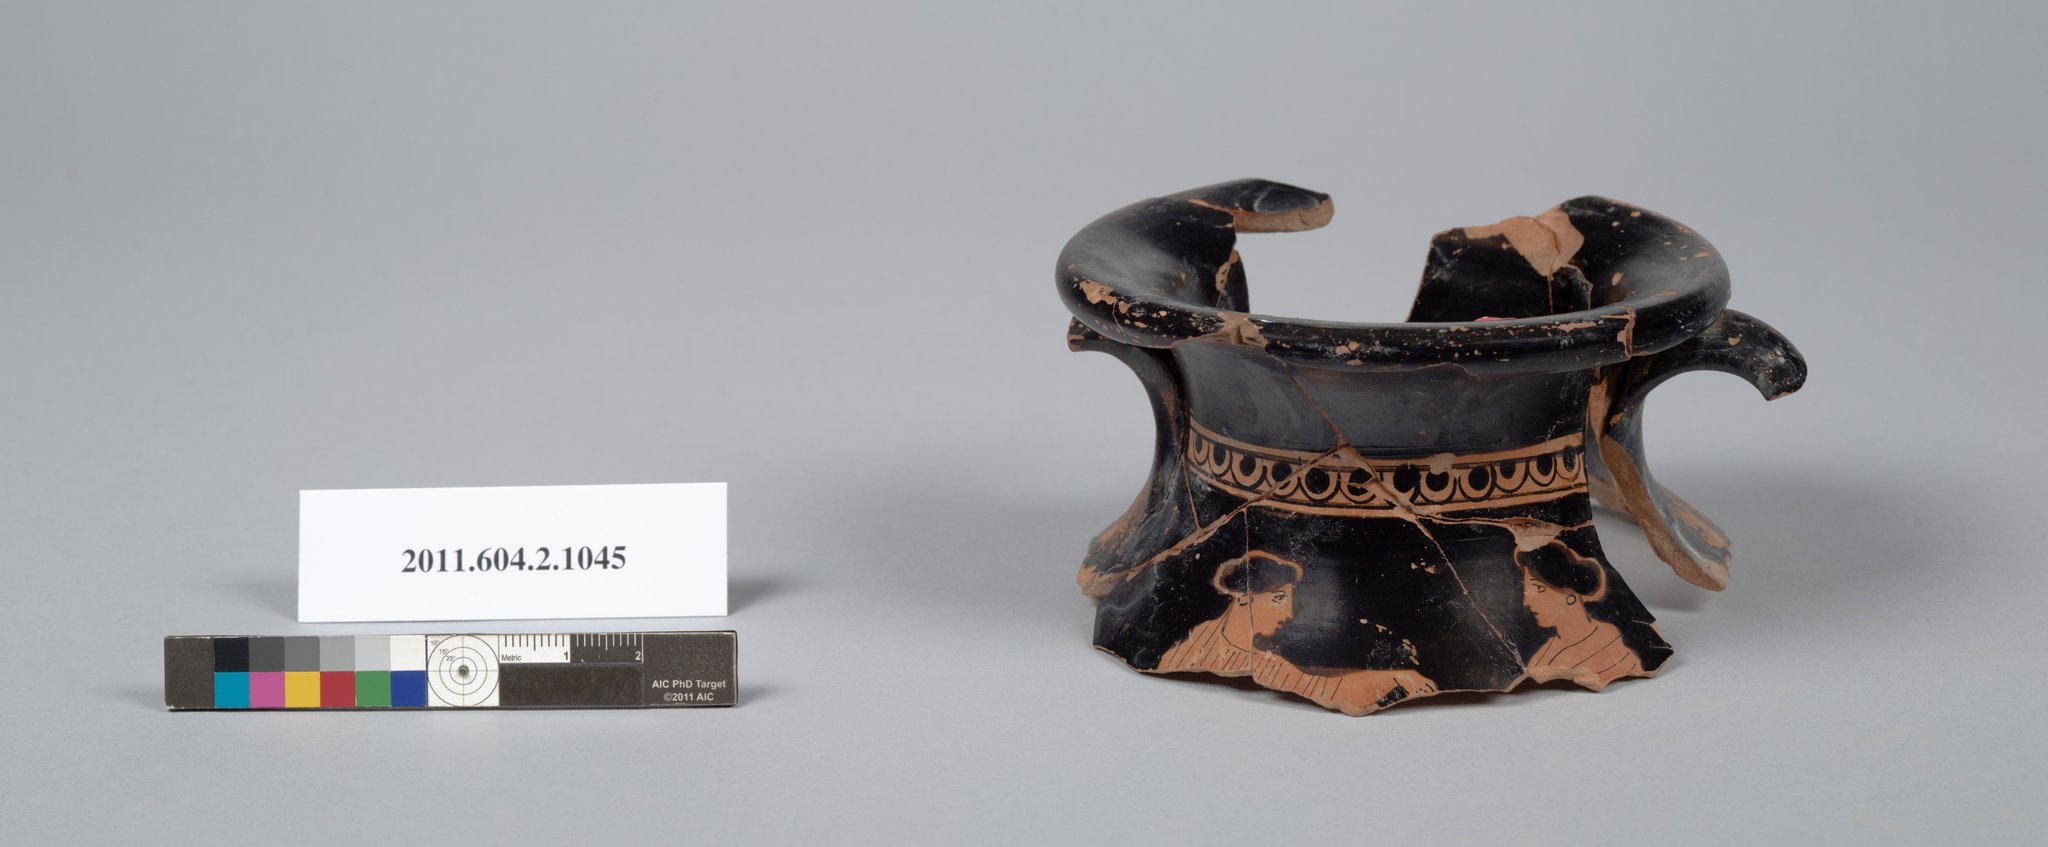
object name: pelike fragment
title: Terracotta fragment of a pelike (jar)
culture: greek, attic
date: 450-426 BCE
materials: terracotta